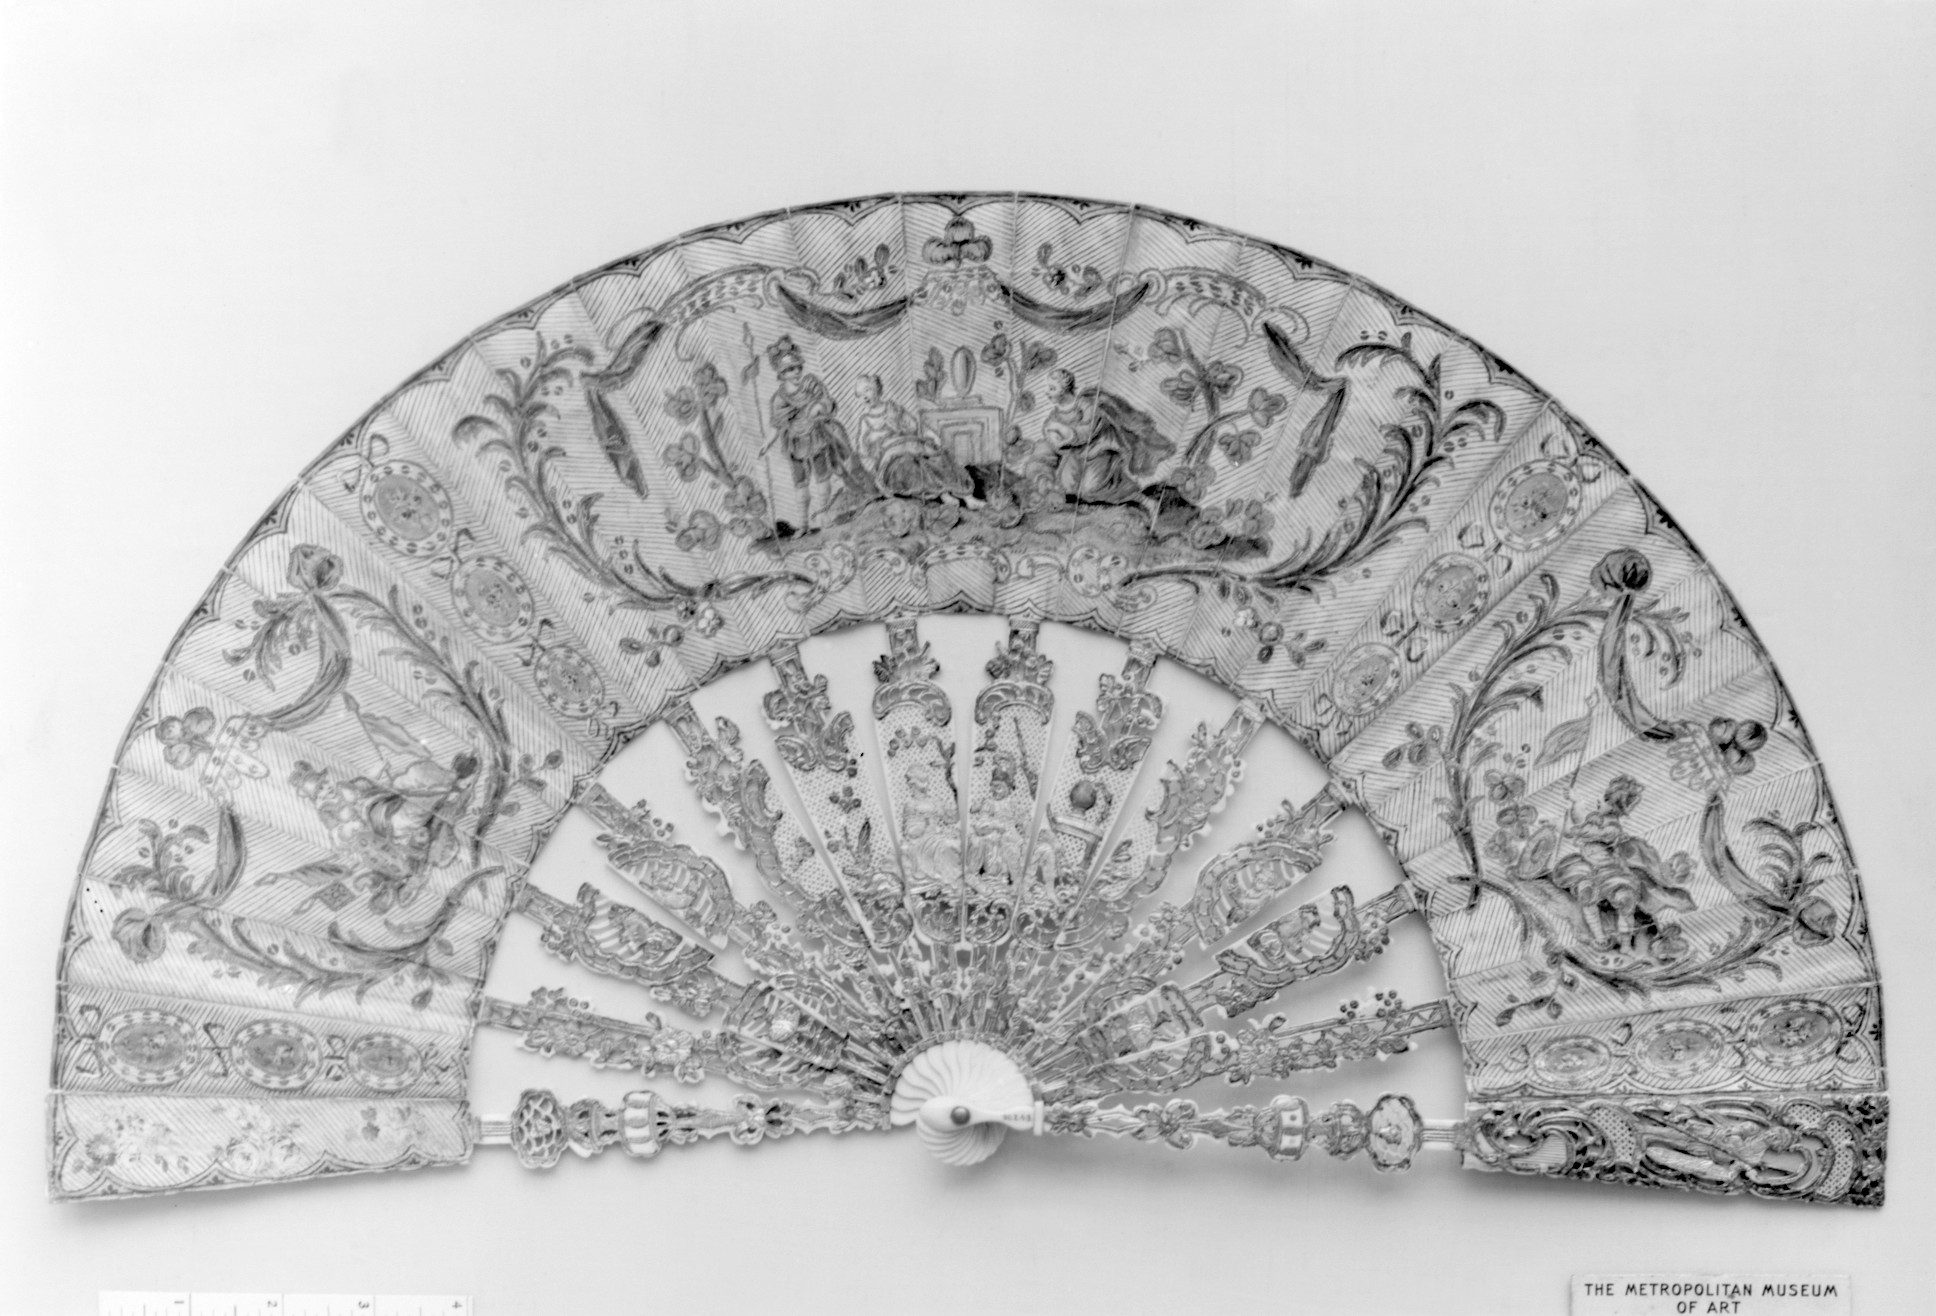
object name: fan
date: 1774-1793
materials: gold, ivory, silk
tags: men,women